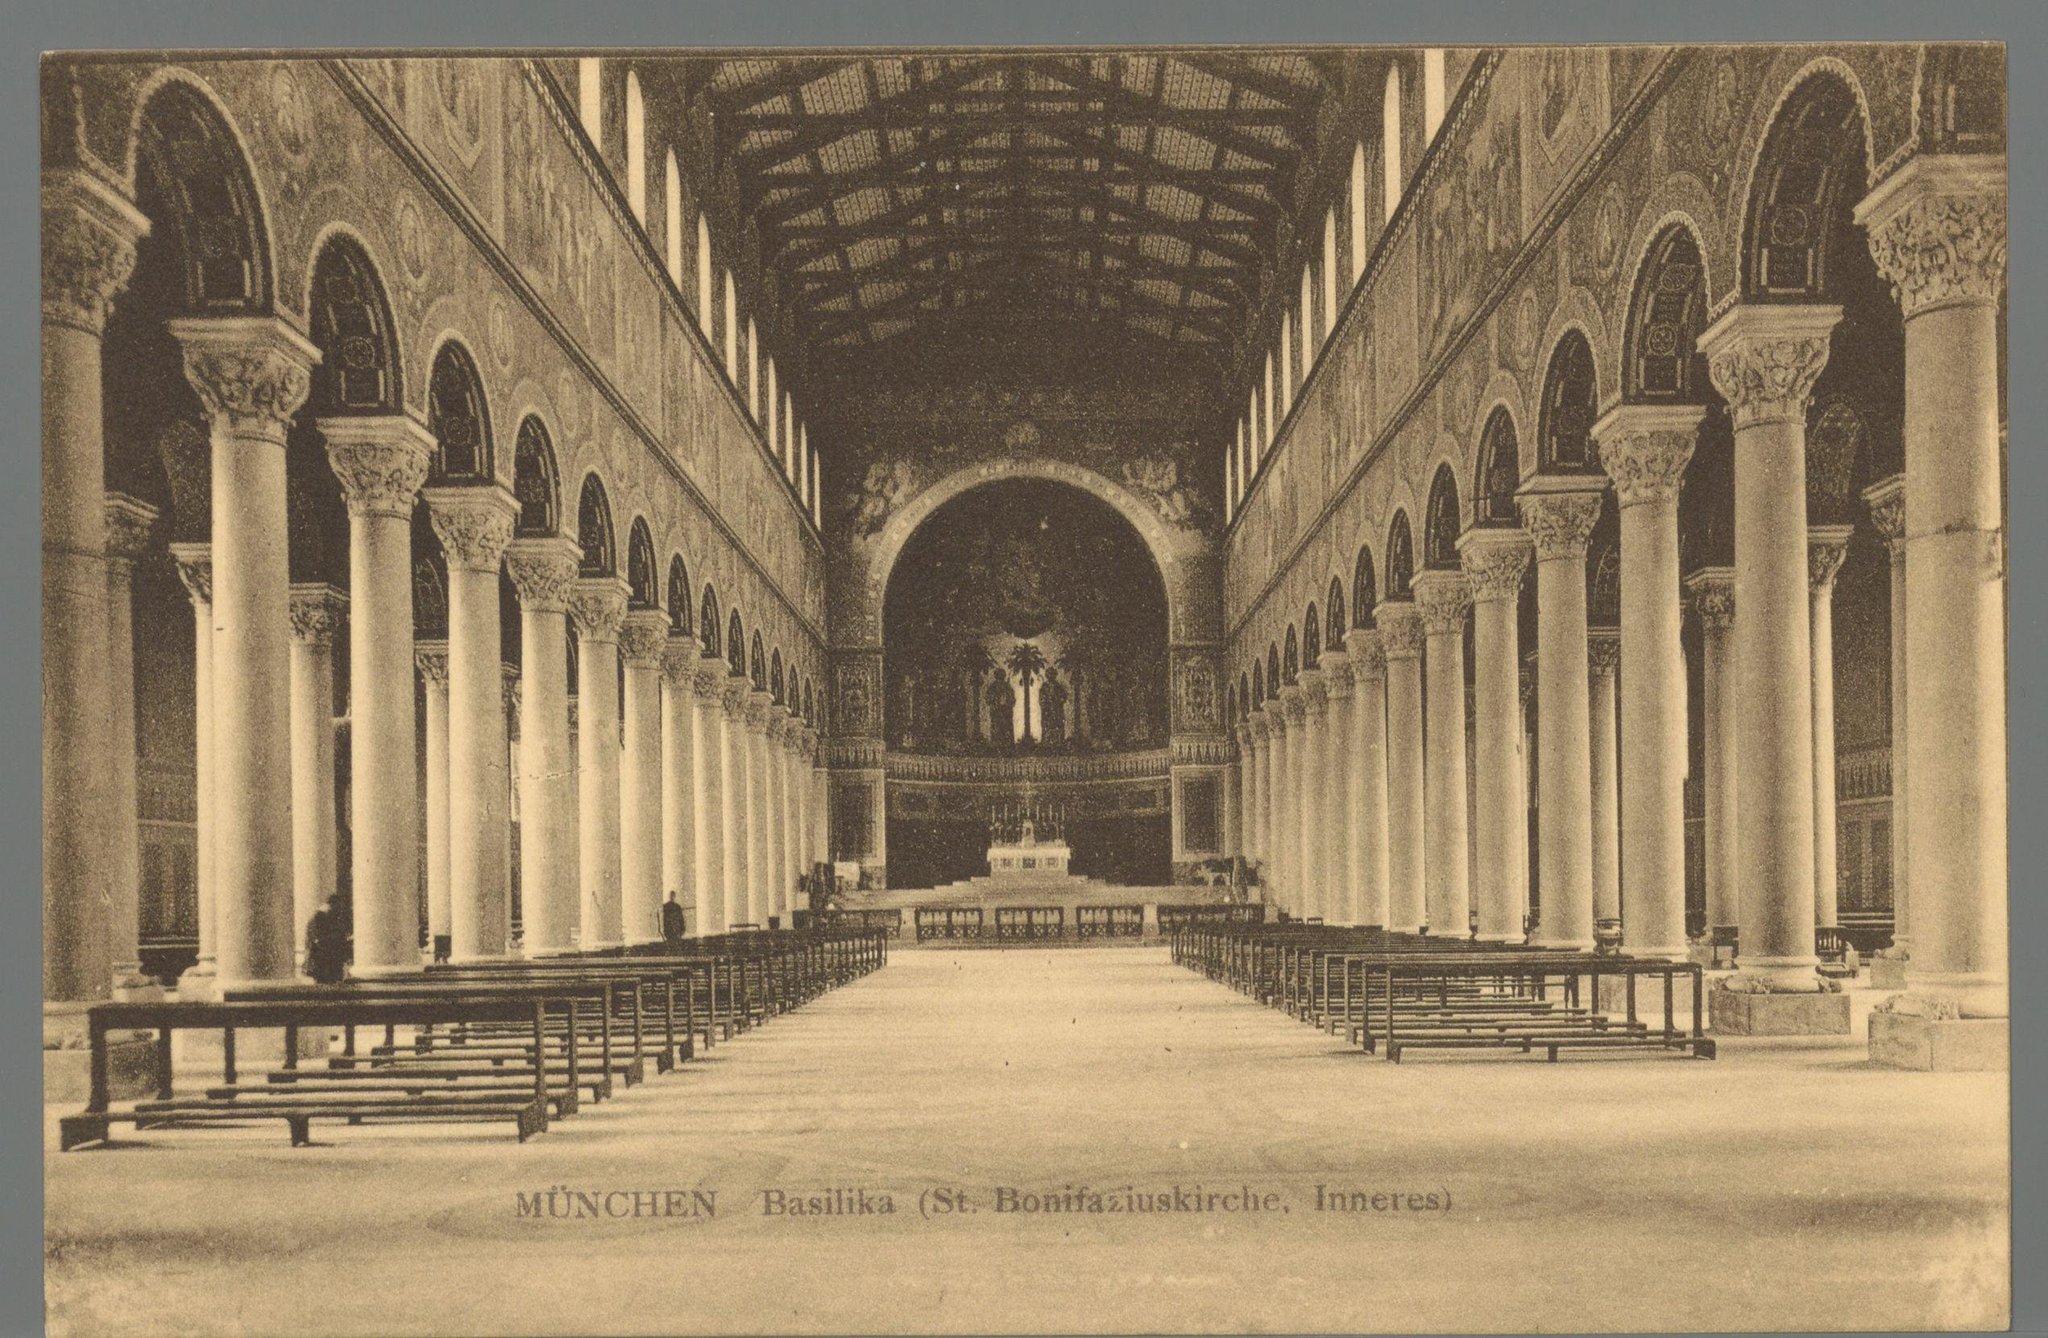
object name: photomechanical print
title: München. Basilika (St. Bonifaziuskirche, Inneres)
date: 1905-1930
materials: cardboard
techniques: photograph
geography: munich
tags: abbey, monastery, convent ~ roman catholic church, interior of church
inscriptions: inscription: ‘W.H.D.’